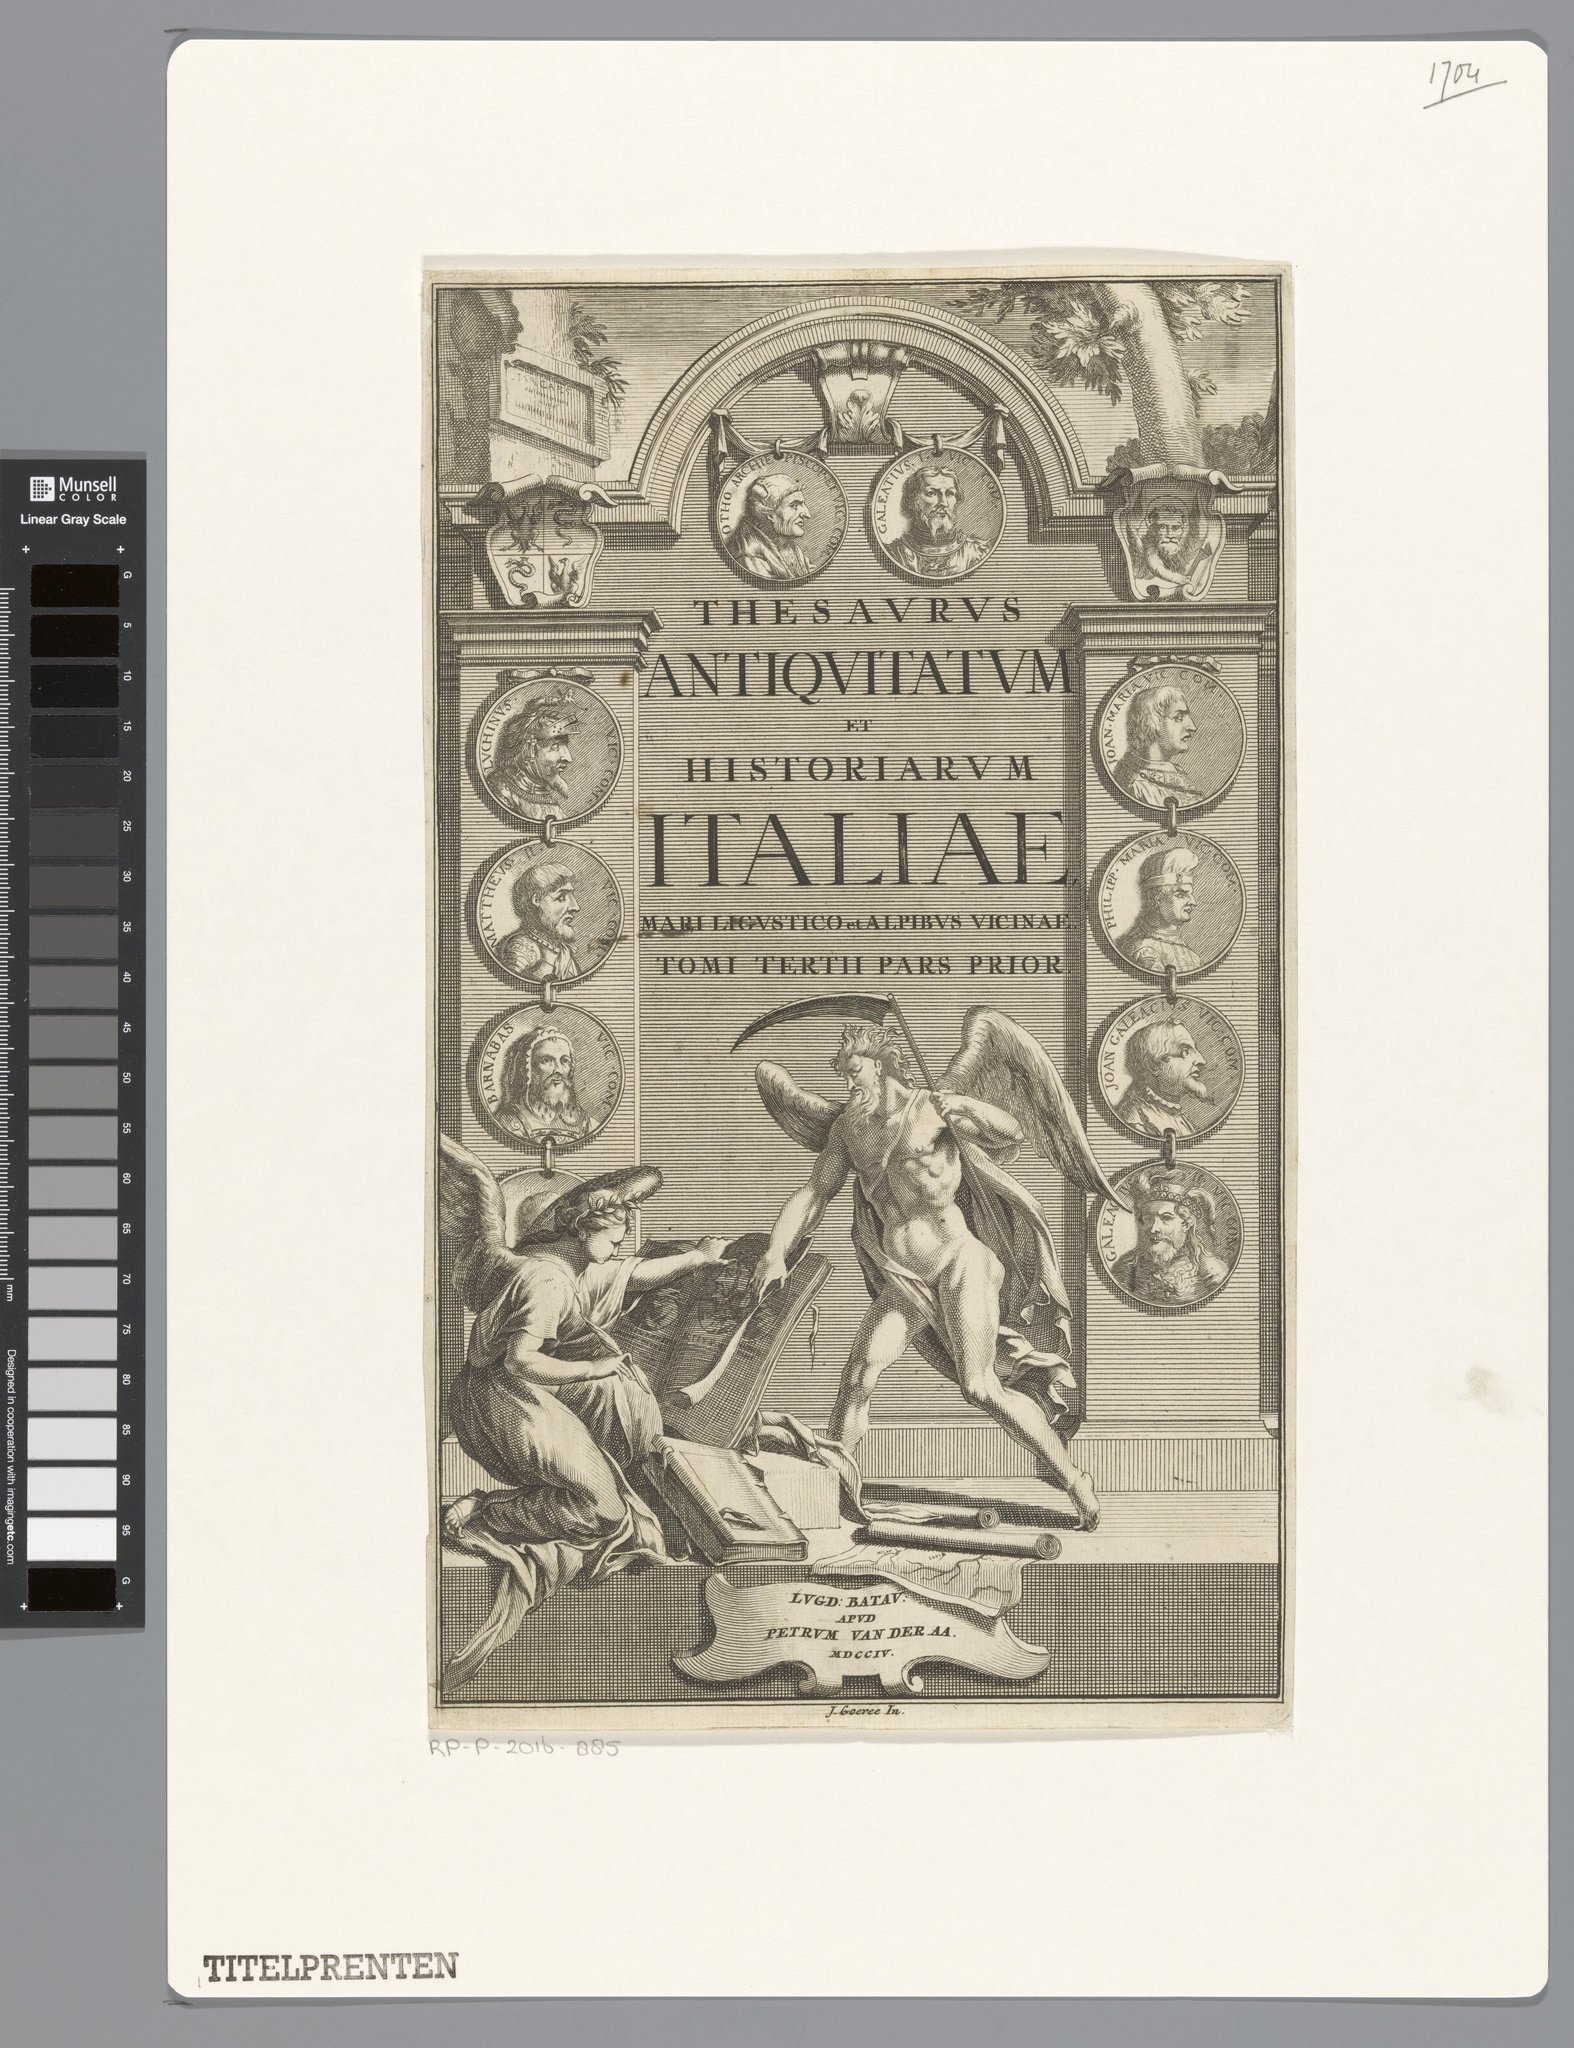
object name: print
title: Titelpagina voor: Johannes Georgius Graevius, Thesaurus antiquitatum et historiarum Italiae, 1704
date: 1704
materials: paper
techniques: engraving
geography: leiden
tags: ornament ~ medallion, 'historia'; 'historia' (ripa), father time, man with wings and scythe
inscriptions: collector's mark: Lugt 2228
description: Titelpagina voor: Graevius, Johannes Georgius. Thesaurus antiquitatum et historiarum Italiae, Tomi tertii pars prior. Leiden: Aa, Pieter van der, 1704. Prent afkomstig uit een plakalbum met titelprenten, ornamenten etc. op blauw papier in 1983 uit elkaar gehaald.